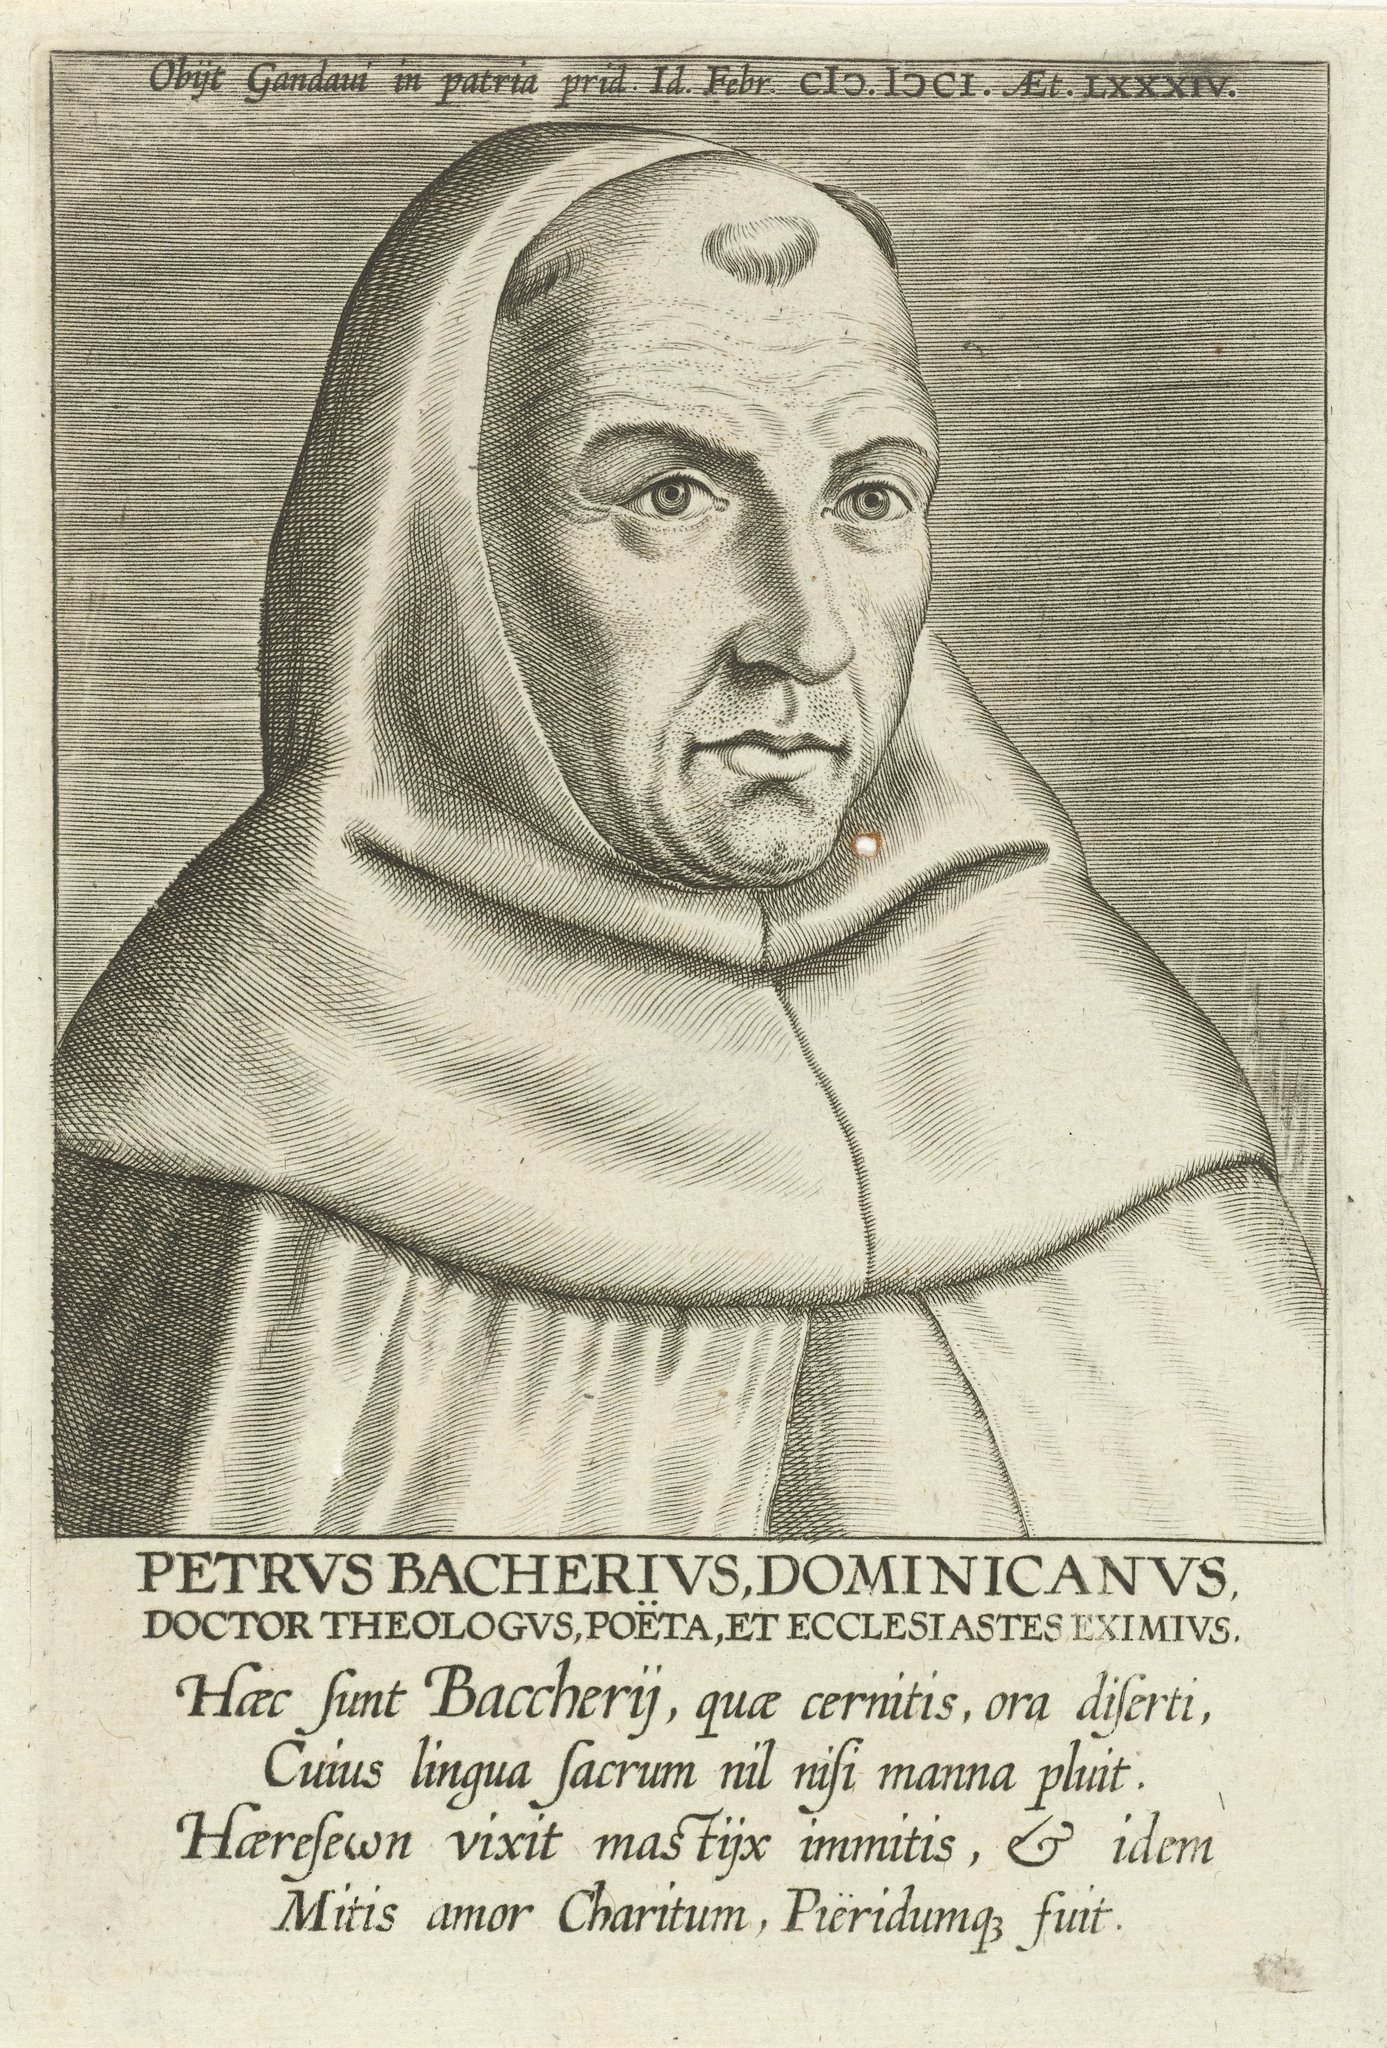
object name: book illustration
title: Portret van Petrus de Backere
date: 1604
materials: paper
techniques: engraving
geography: brussels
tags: ghent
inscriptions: collector's mark: Lugt 2228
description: Portret van Petrus de Backere, Dominicaner monnik en inquisiteur van Vlaanderen. Buste naar rechts. De prent heeft een Latijns boven- en onderschrift en maakt deel uit van een serie van bekende schrijvers uit de Nederlanden.